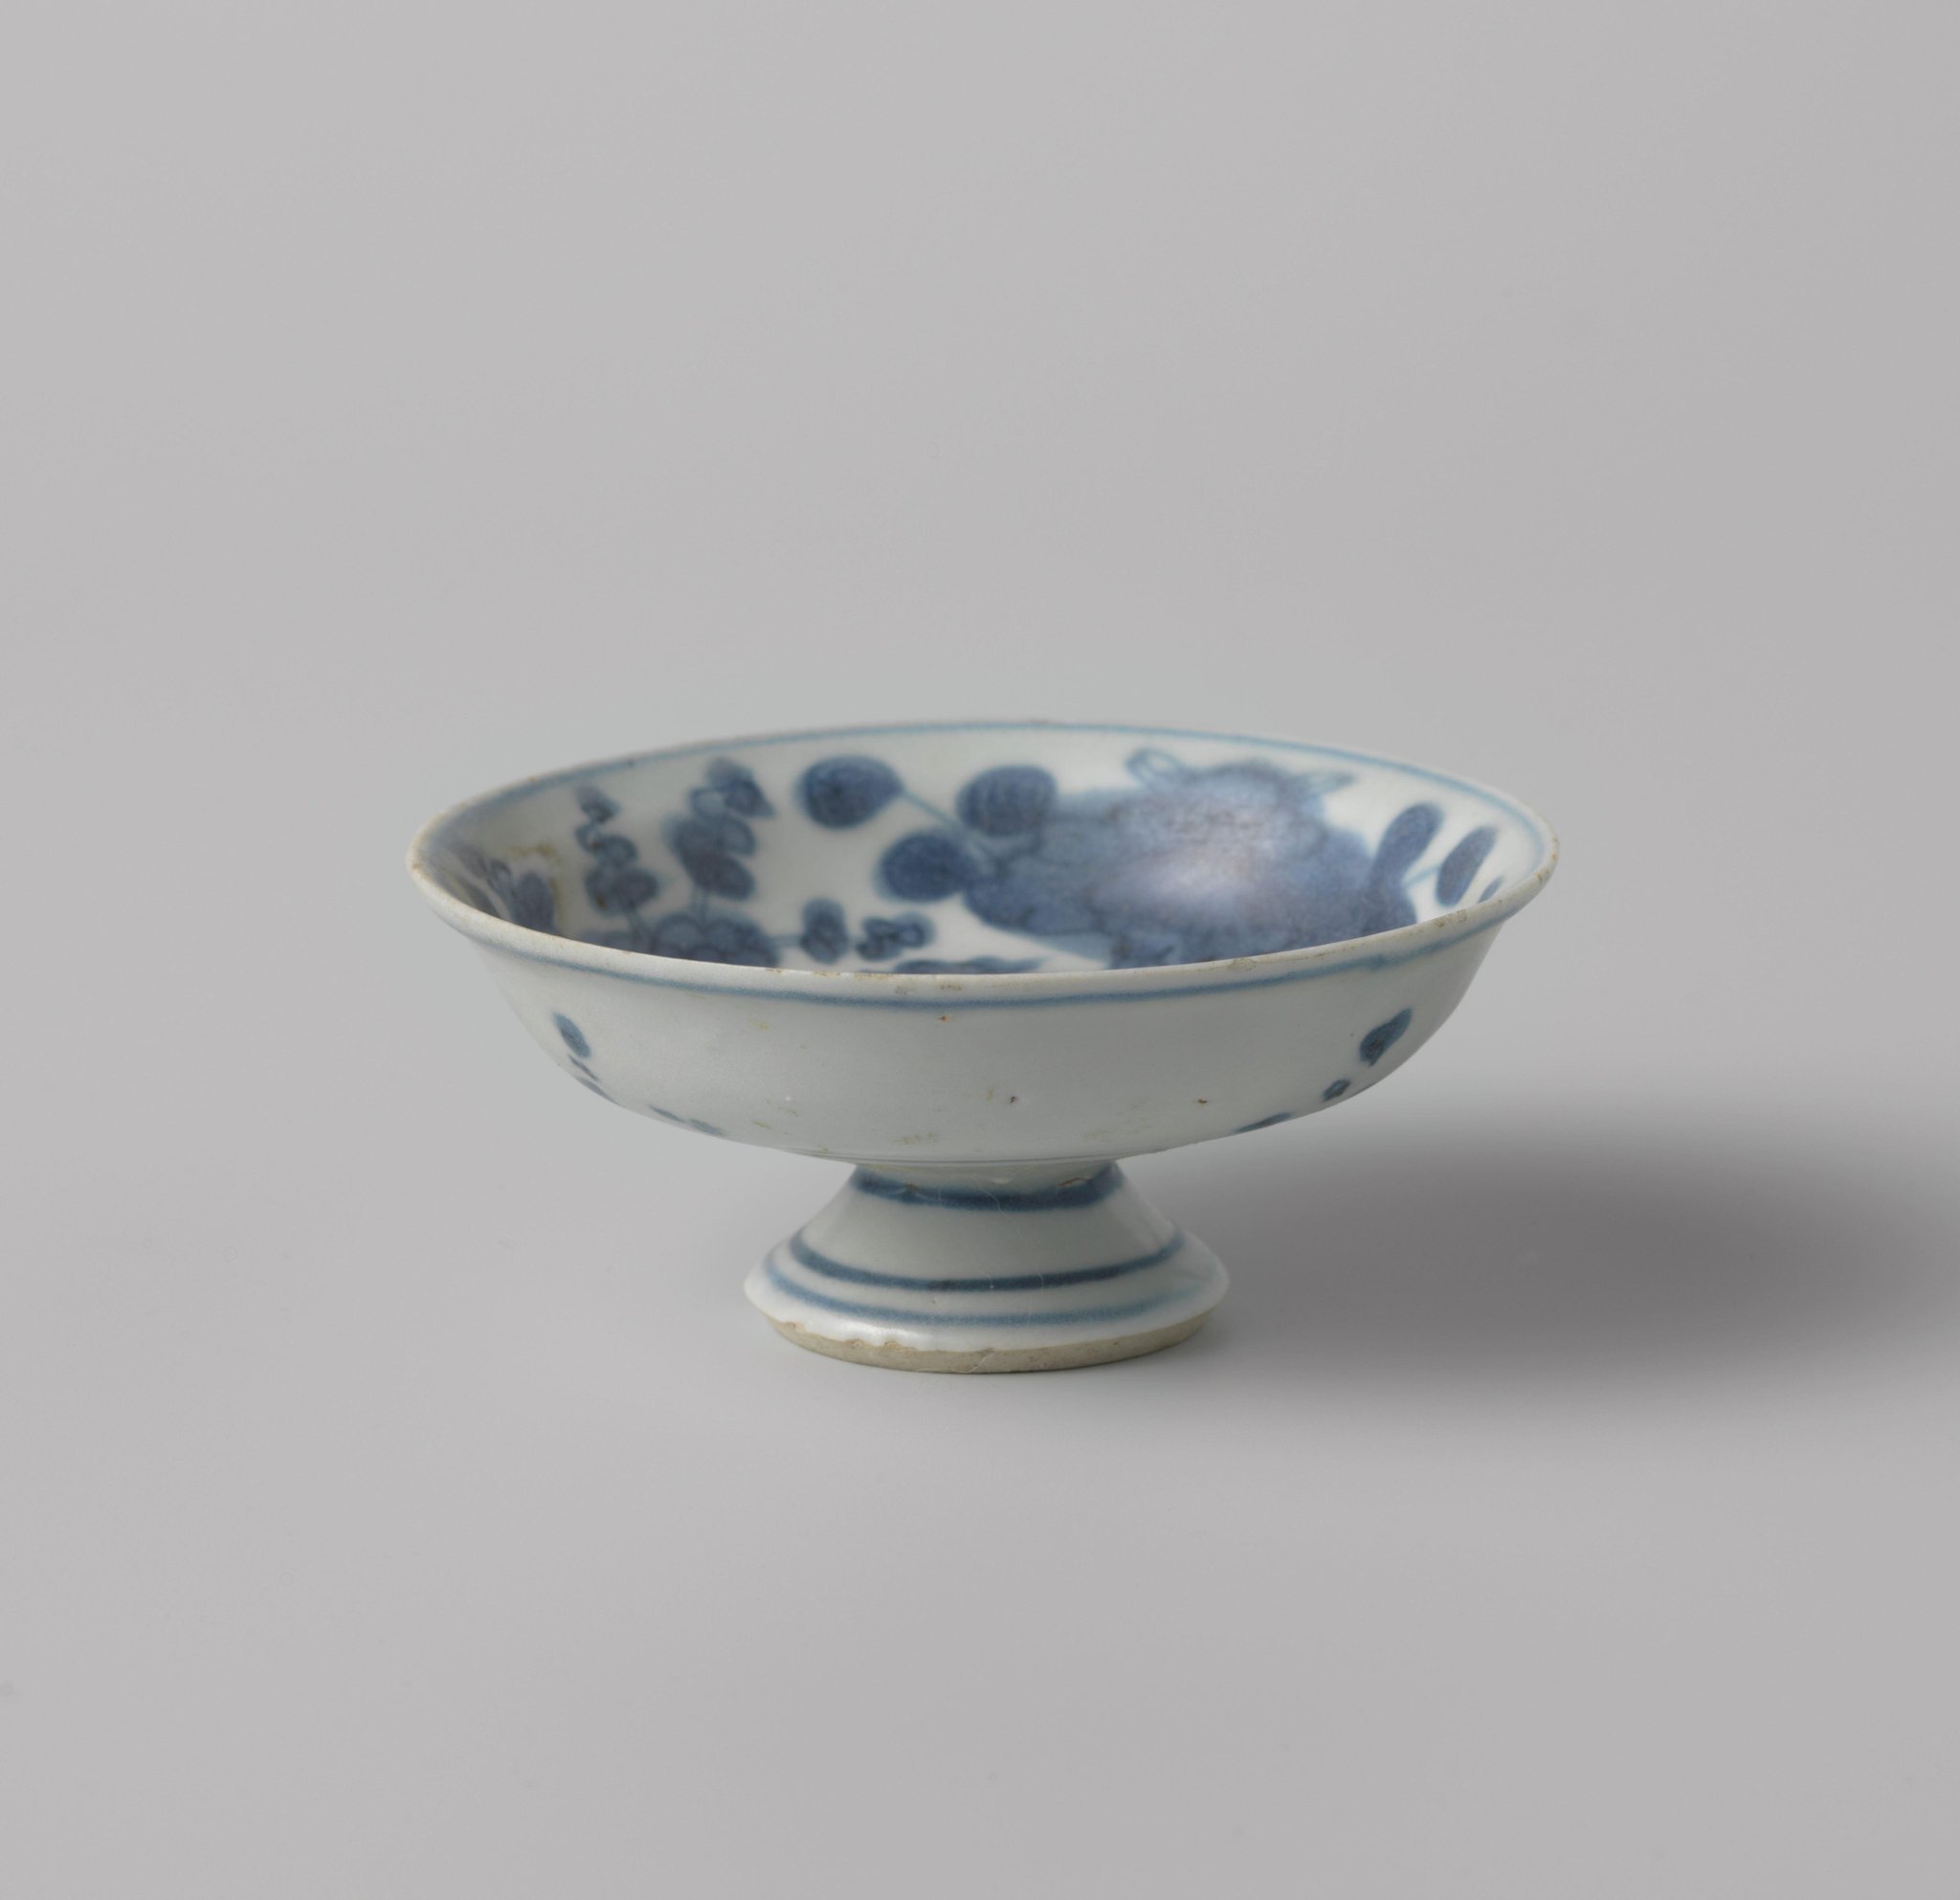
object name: dish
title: Tazza of Chinese porcelain from the wreck of the Dutch East Indiaman Witte Leeuw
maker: Anonymous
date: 1613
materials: glaze, porcelain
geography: swatow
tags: verenigde oostindische compagnie, sint-helena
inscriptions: mark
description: A Tazza. In the centre an unclear motive is drawn encircled by a double band on which is drawn clockwise a peony, a spray of peaches, a chrysanthemum and prunus flowers. Between them tufts of grass. On the outside three groups of dots are drawn. The trapezium-shaped foot is thick and decorated with two bands. On the base a reign mark is handwritten: cheng hua nien chih.